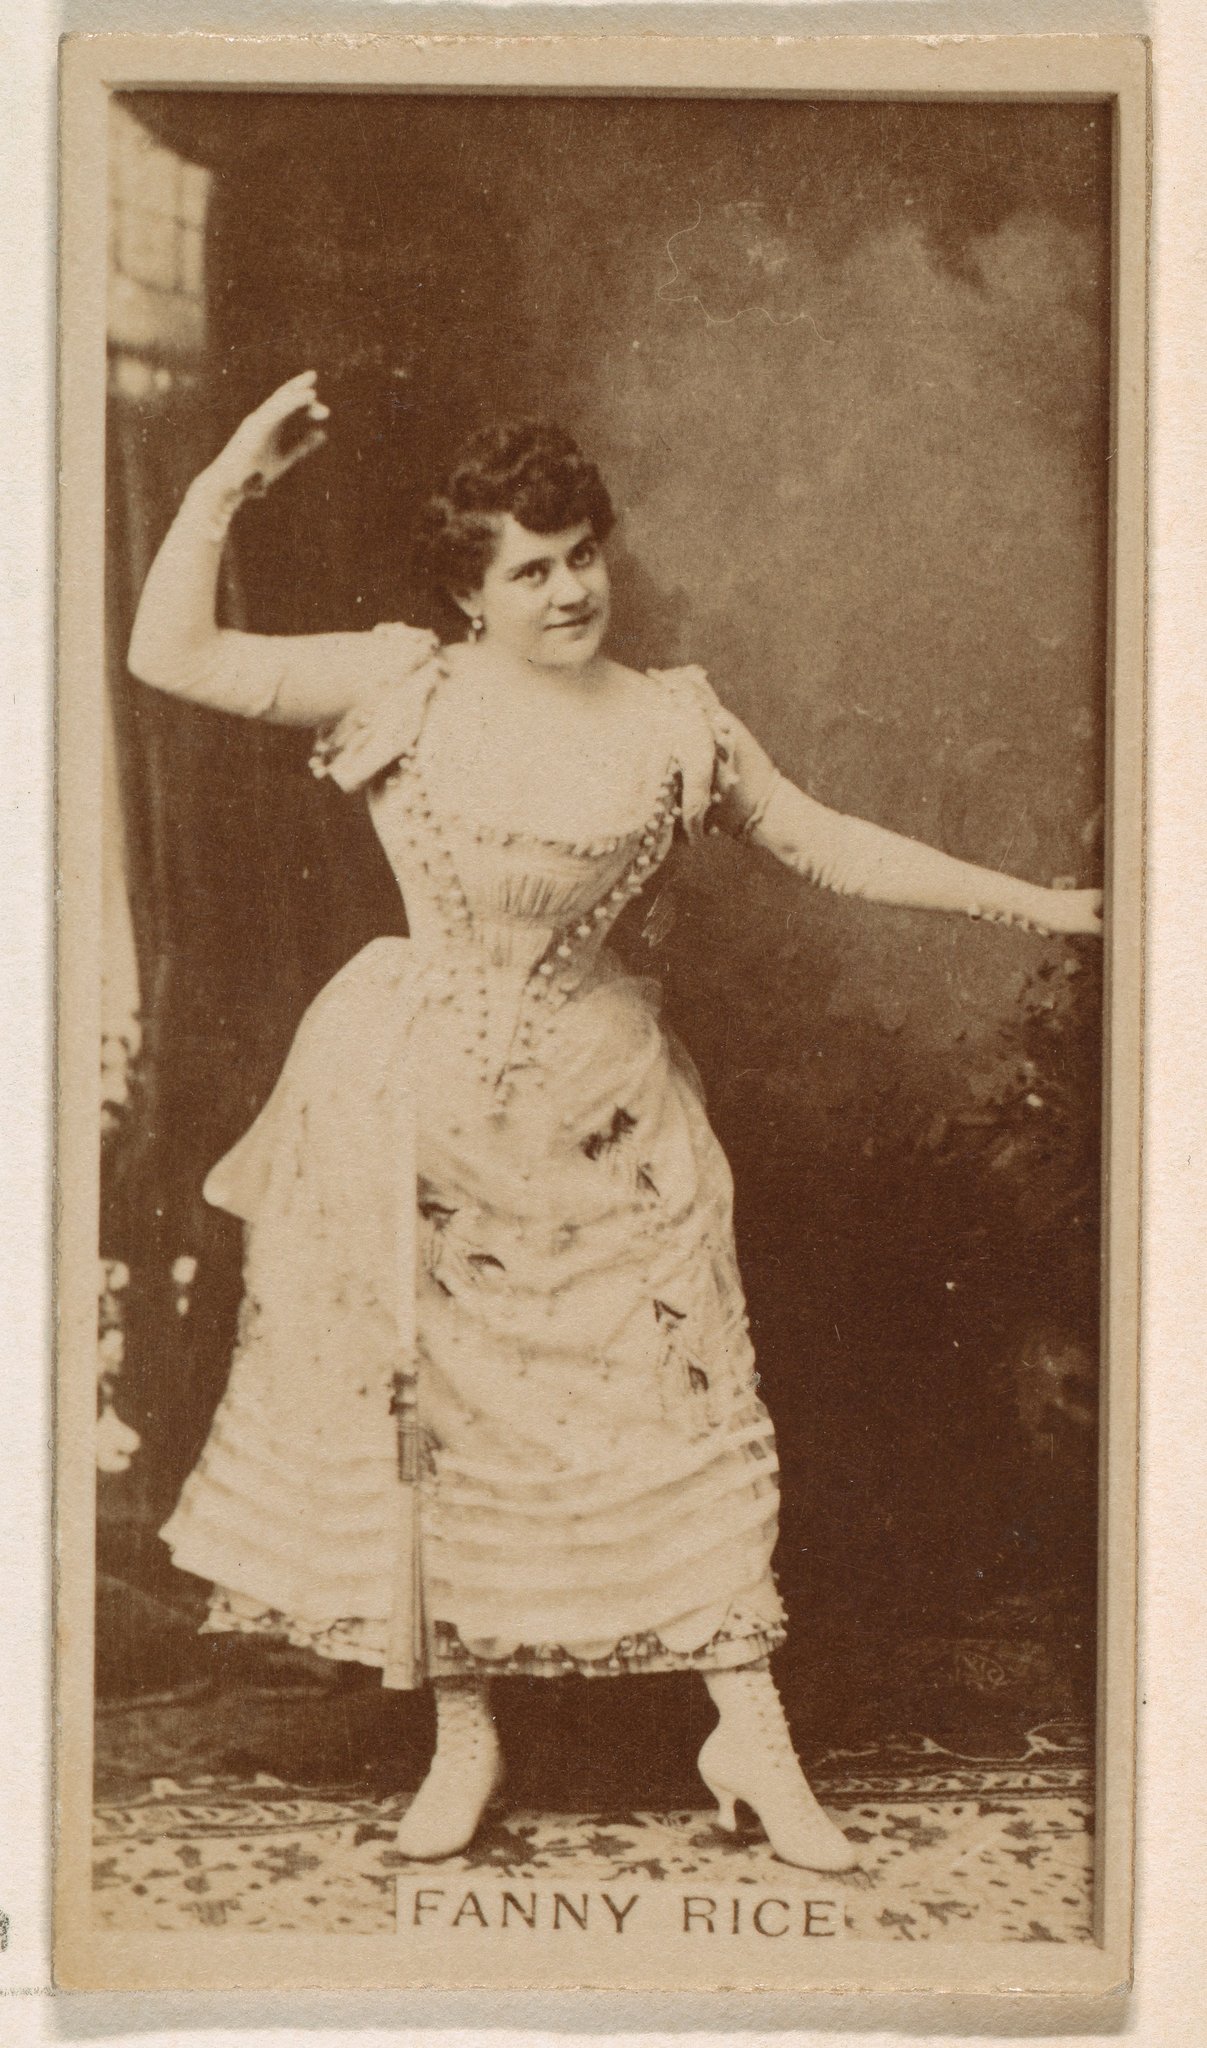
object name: photograph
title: Fanny Rice, from the Actresses series (N245) issued by Kinney Brothers to promote Sweet Caporal Cigarettes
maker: kinney brothers tobacco company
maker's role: publisher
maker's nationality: american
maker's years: 1869-2011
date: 1890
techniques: albumen silver print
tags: portraits,women,actresses